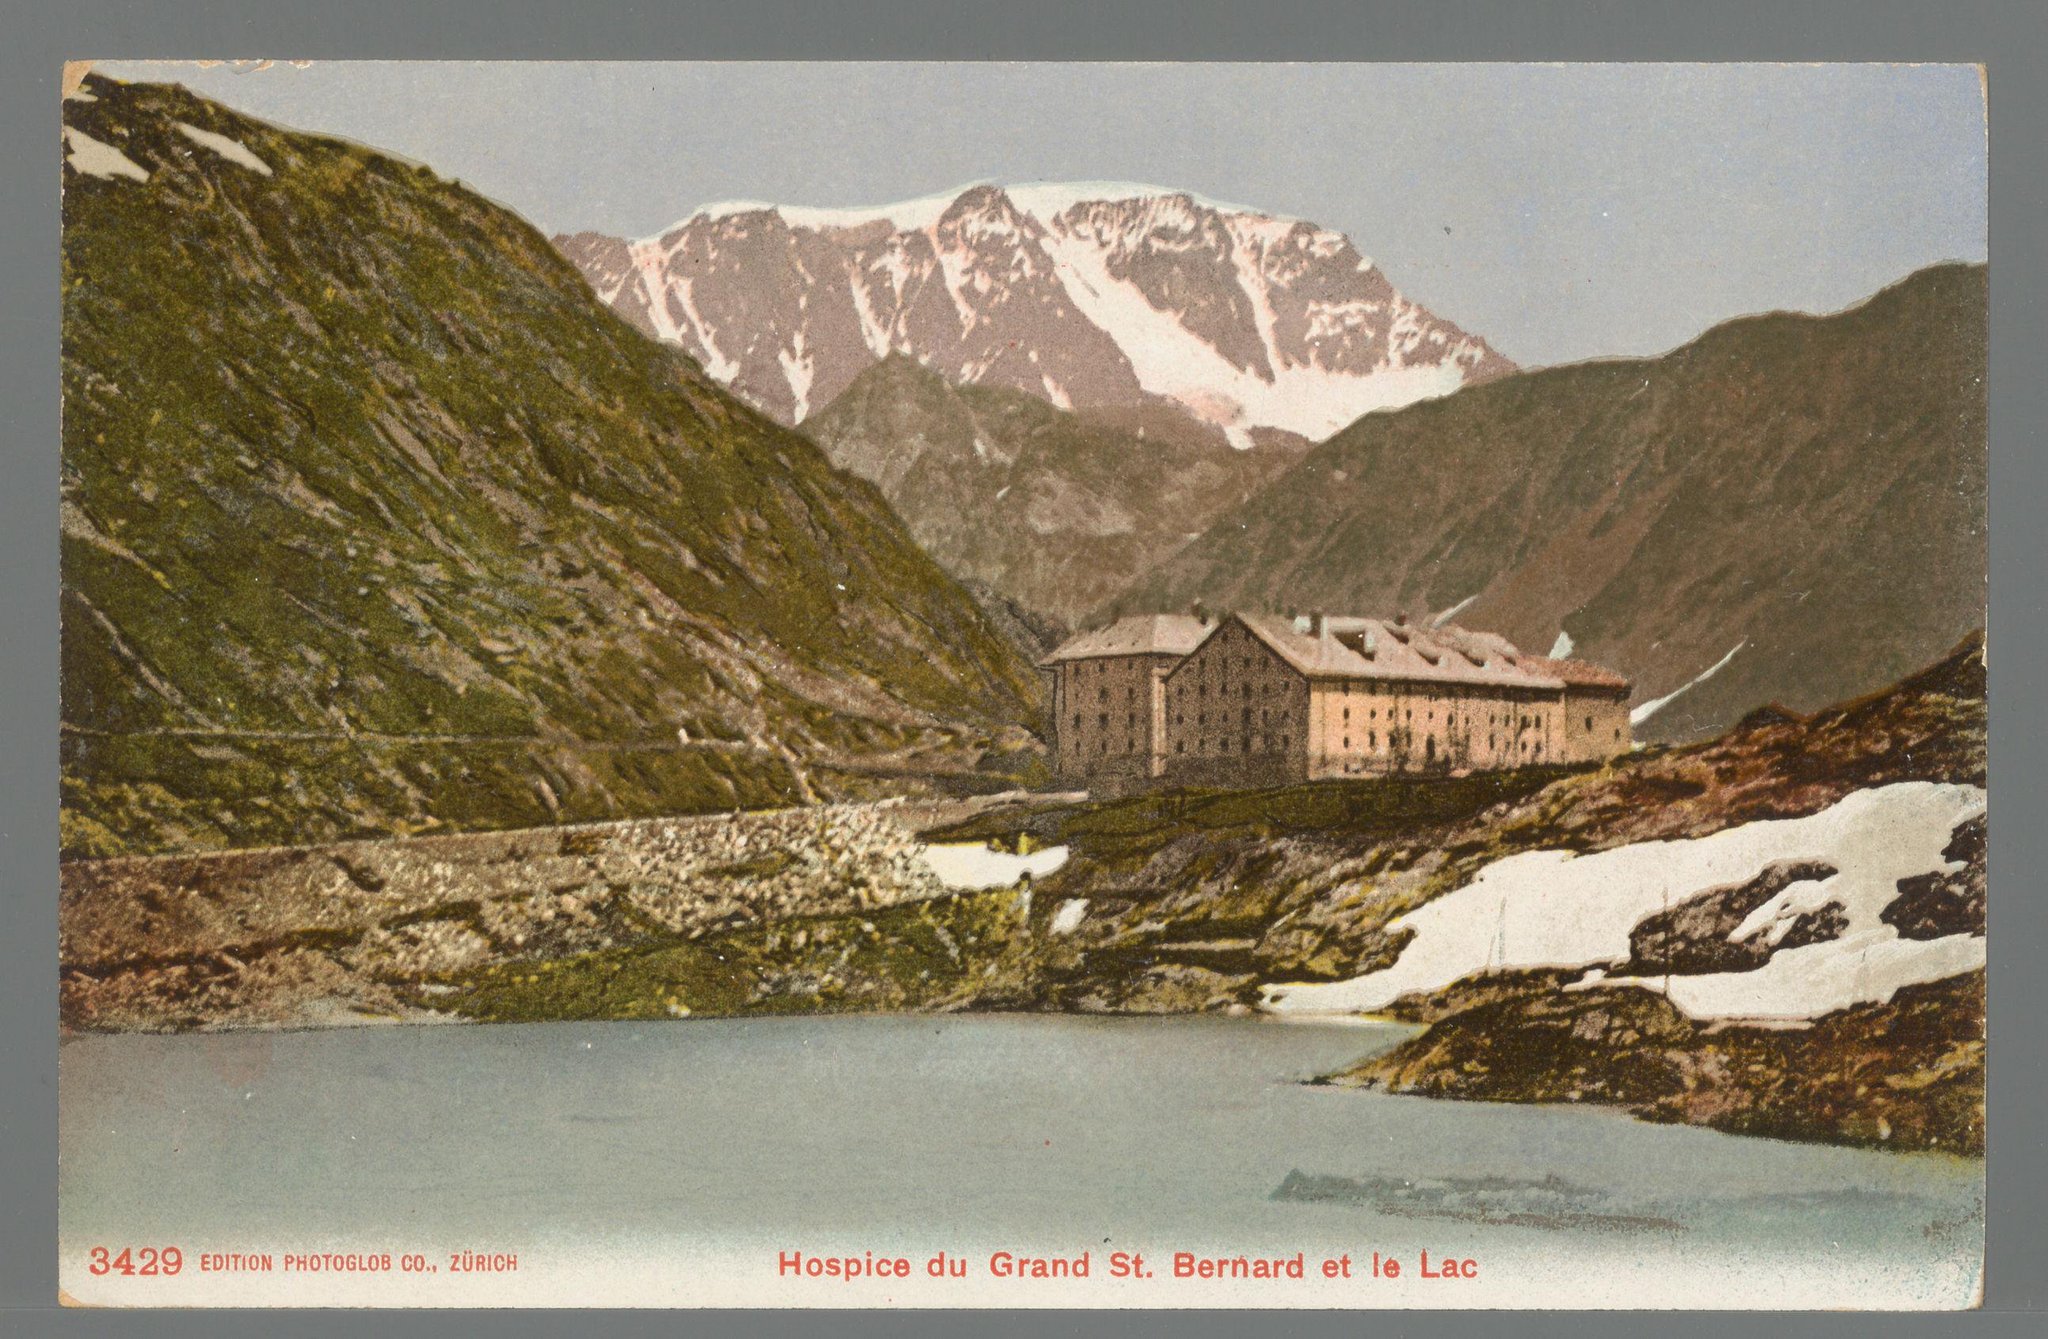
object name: ansichtkaart, prentbriefkaart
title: Hospice du Grand St. Bernard et le Lac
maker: Anonymous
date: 1905-1920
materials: cardboard, photographic process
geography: zurich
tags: lake, mountain-range, snow peaks, hotel, hostelry, inn